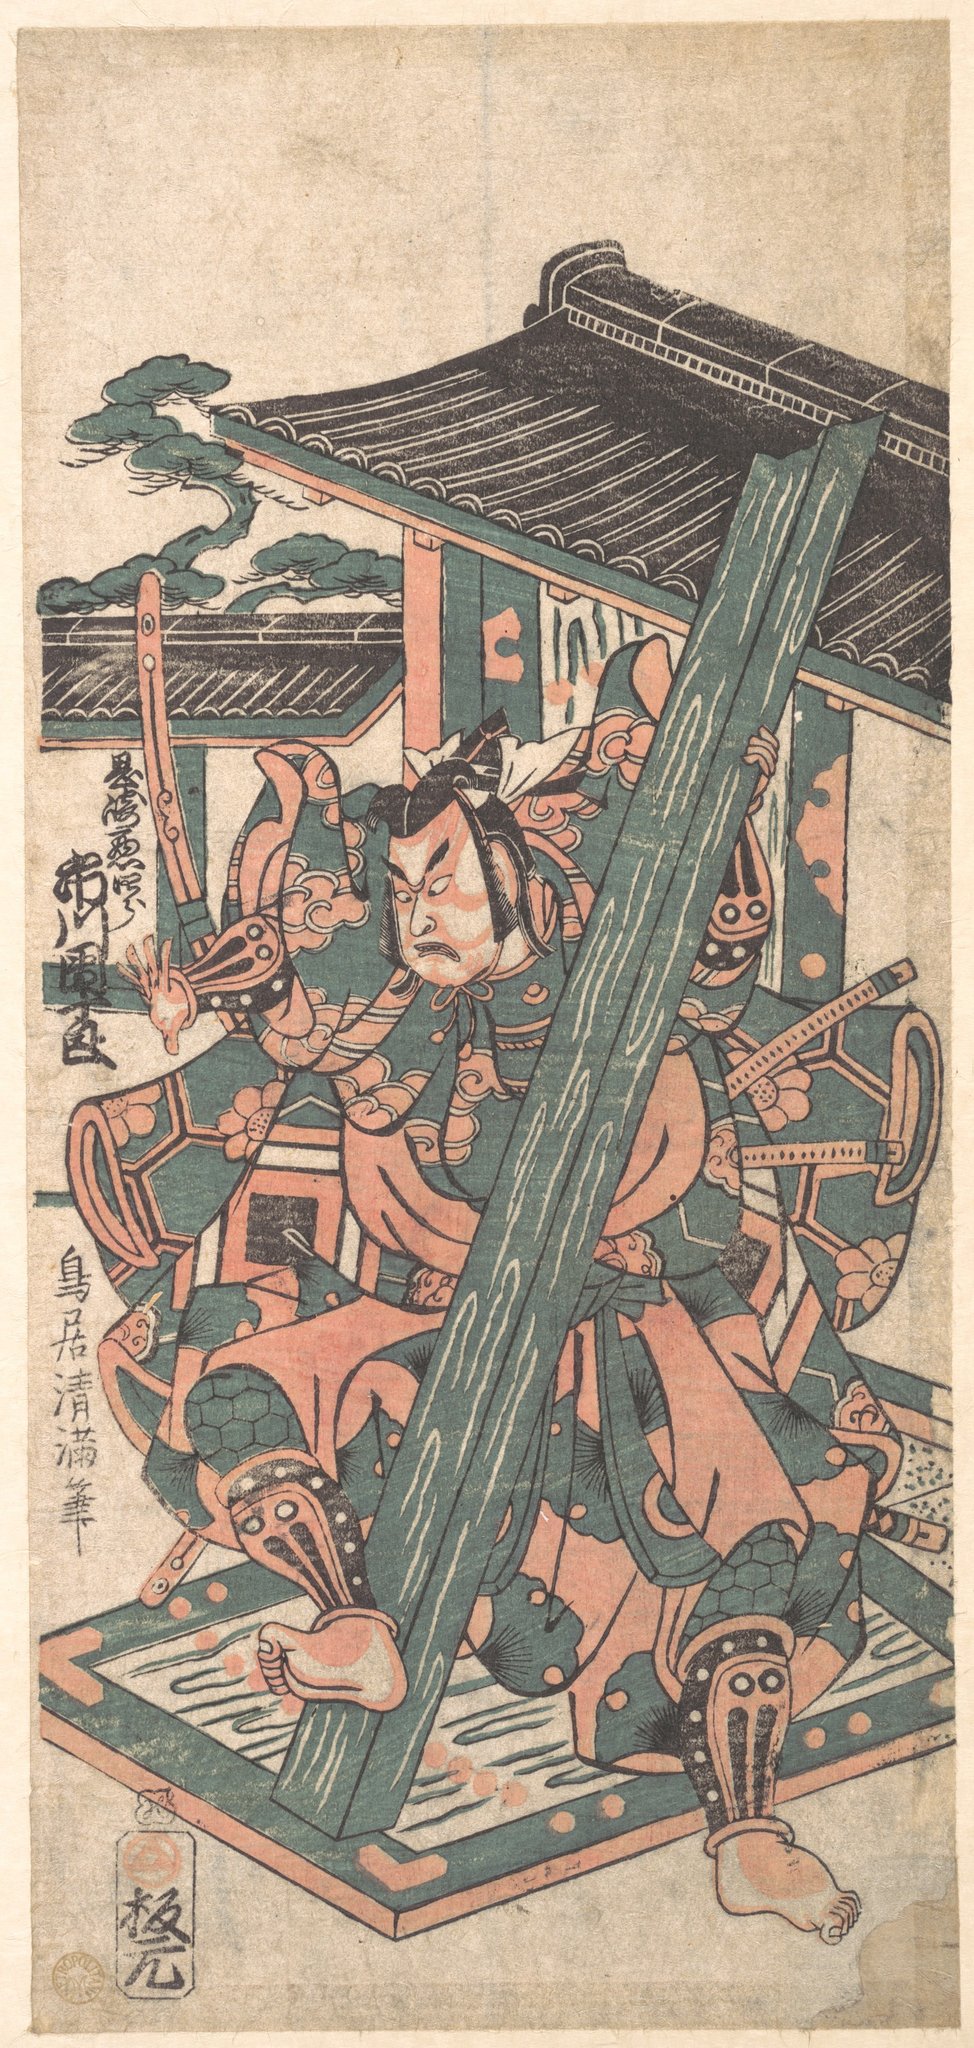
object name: print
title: Ichikawa Danjuro IV in the Role of Okazaki Akushiro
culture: japanese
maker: torii kiyomitsu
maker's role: artist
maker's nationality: japanese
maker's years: 1735-1785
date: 1755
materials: ink, paper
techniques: woodblock print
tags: theatre,men,actors